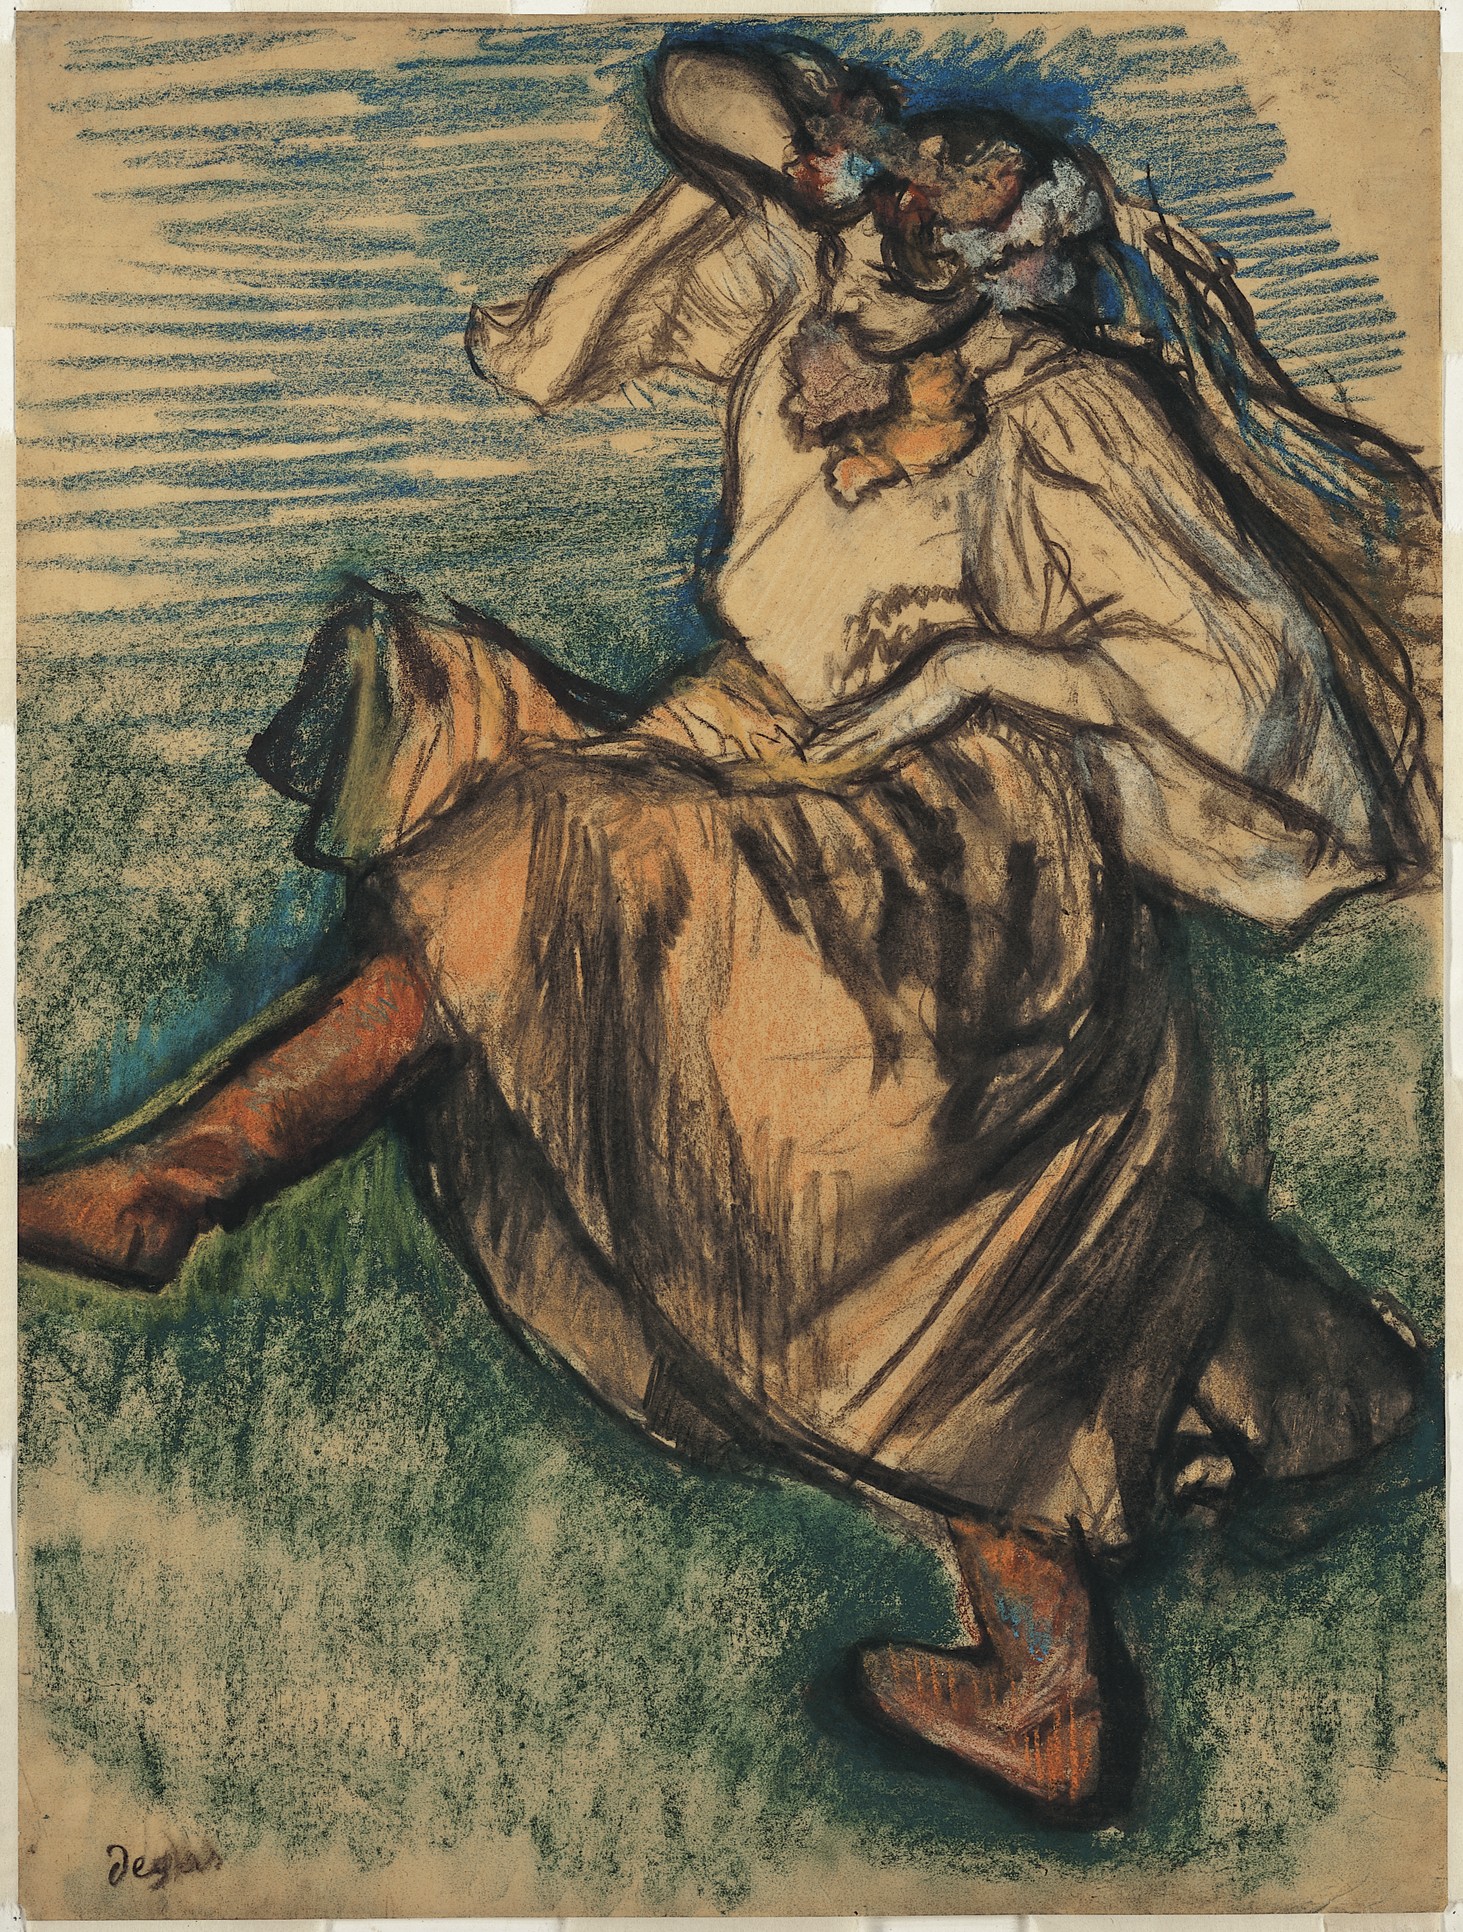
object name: drawing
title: Dancer in Ukrainian Dress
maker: edgar degas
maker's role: artist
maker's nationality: french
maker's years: 1834-1917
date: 1899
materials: charcoal, pastel, paper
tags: women,dancing,dancers